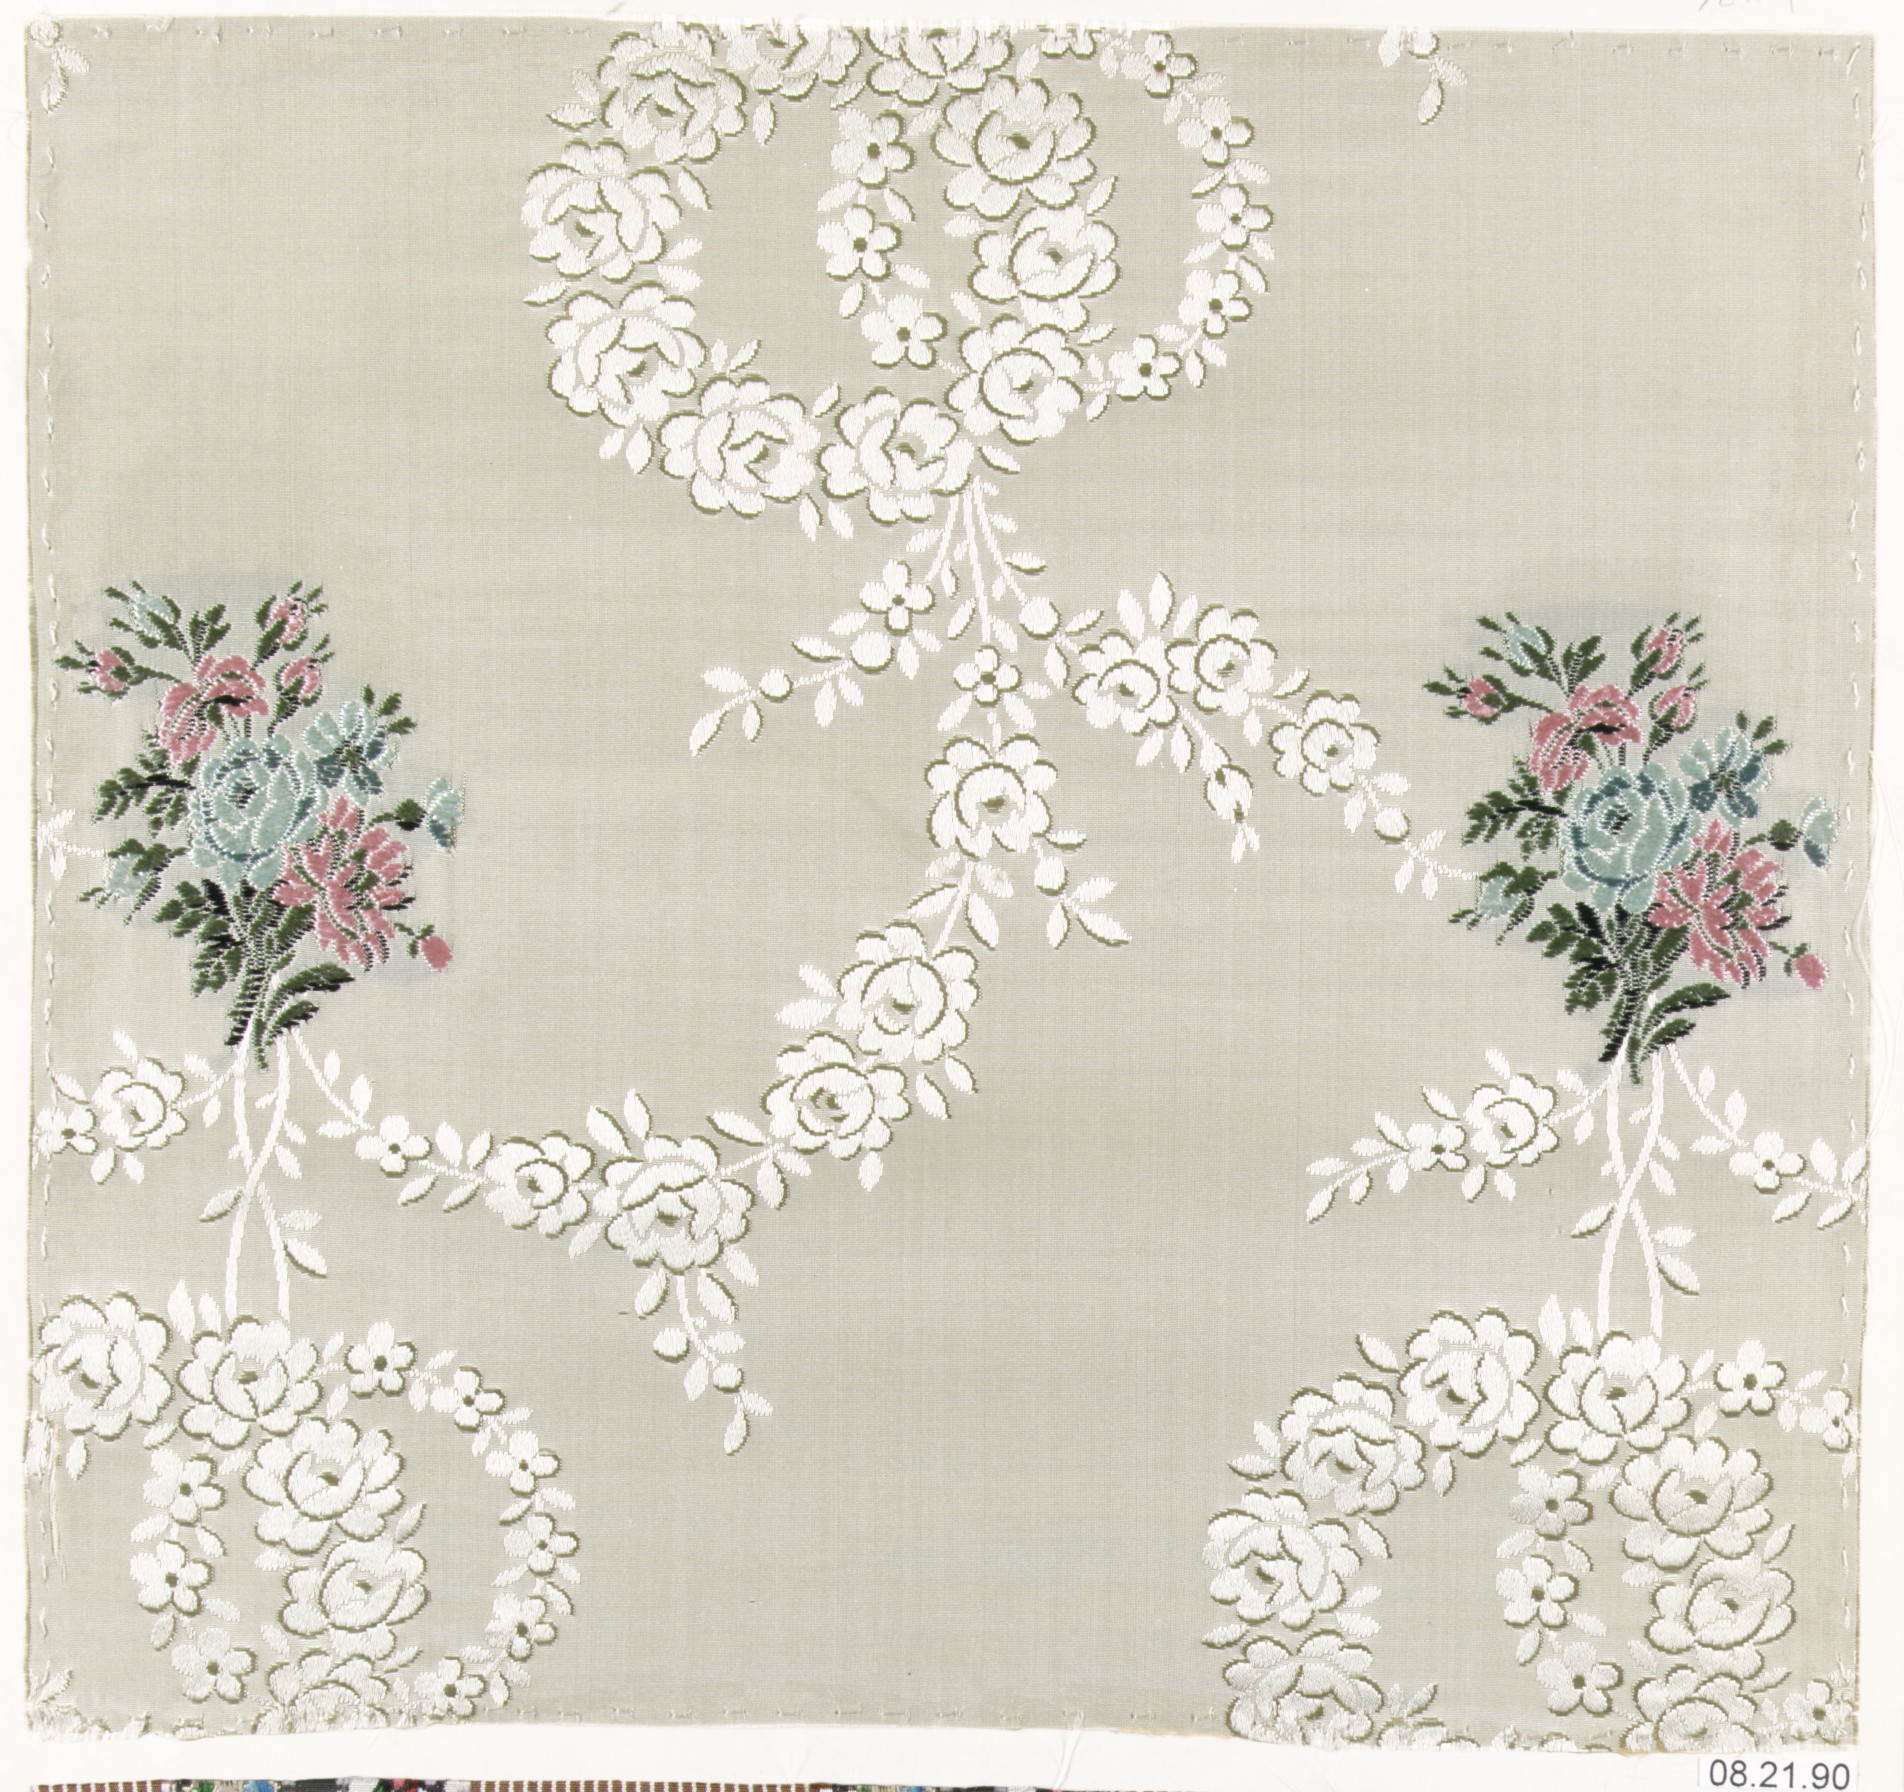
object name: textile sample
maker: Anonymous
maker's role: designer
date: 1900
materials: silk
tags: flowers